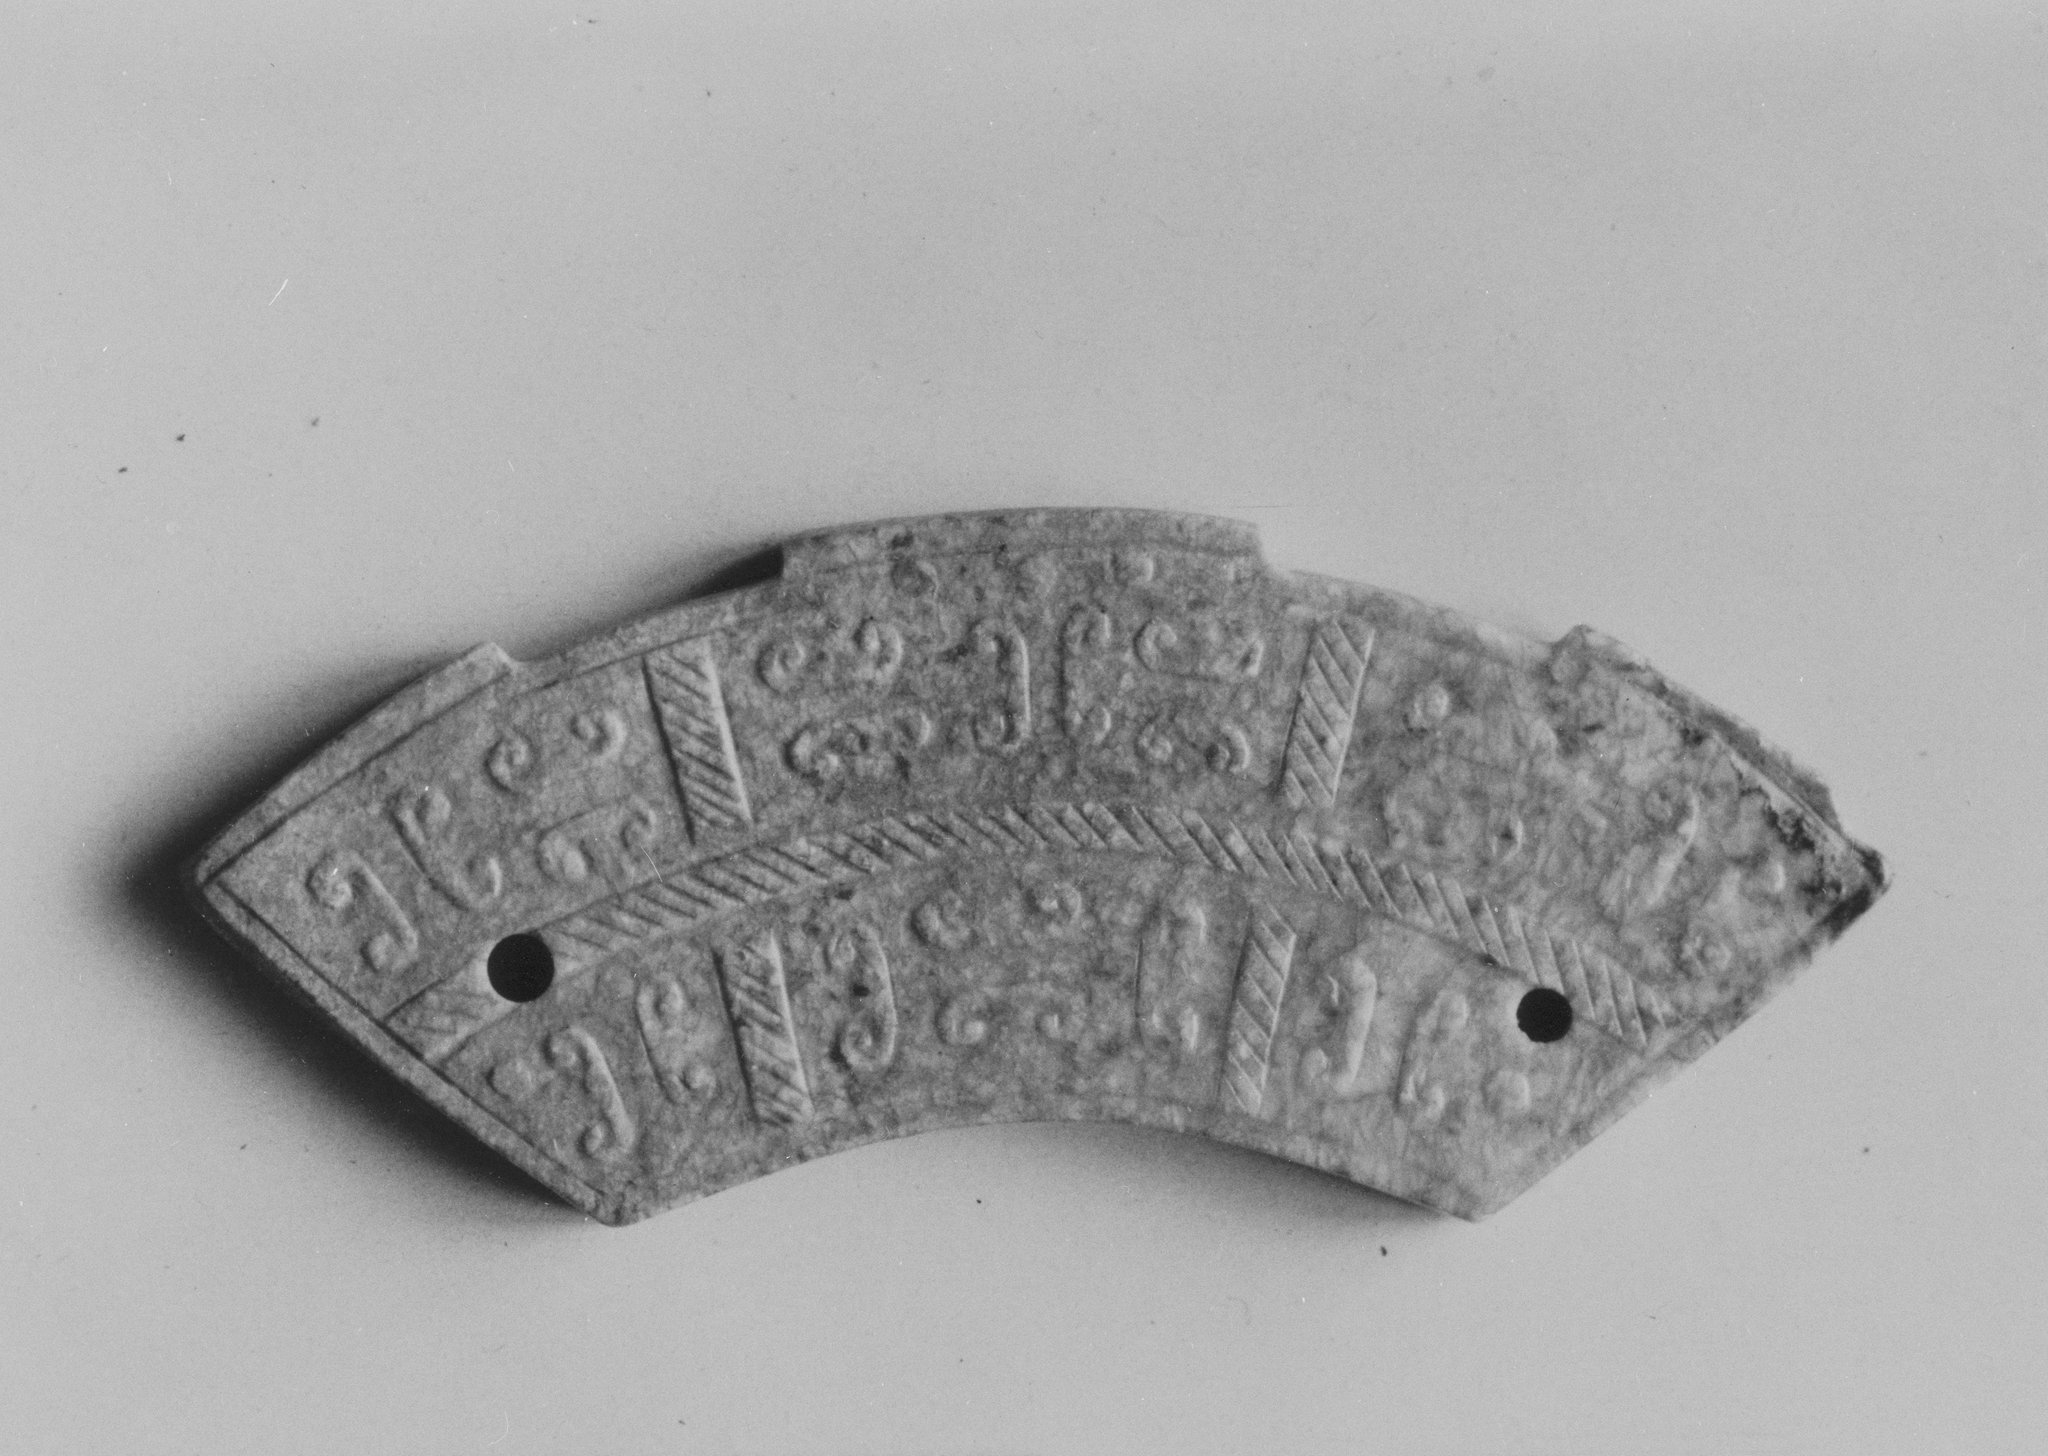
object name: pendant or ornament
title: Pendant Ornament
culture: chinese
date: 206 BCE-220 CE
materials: jade